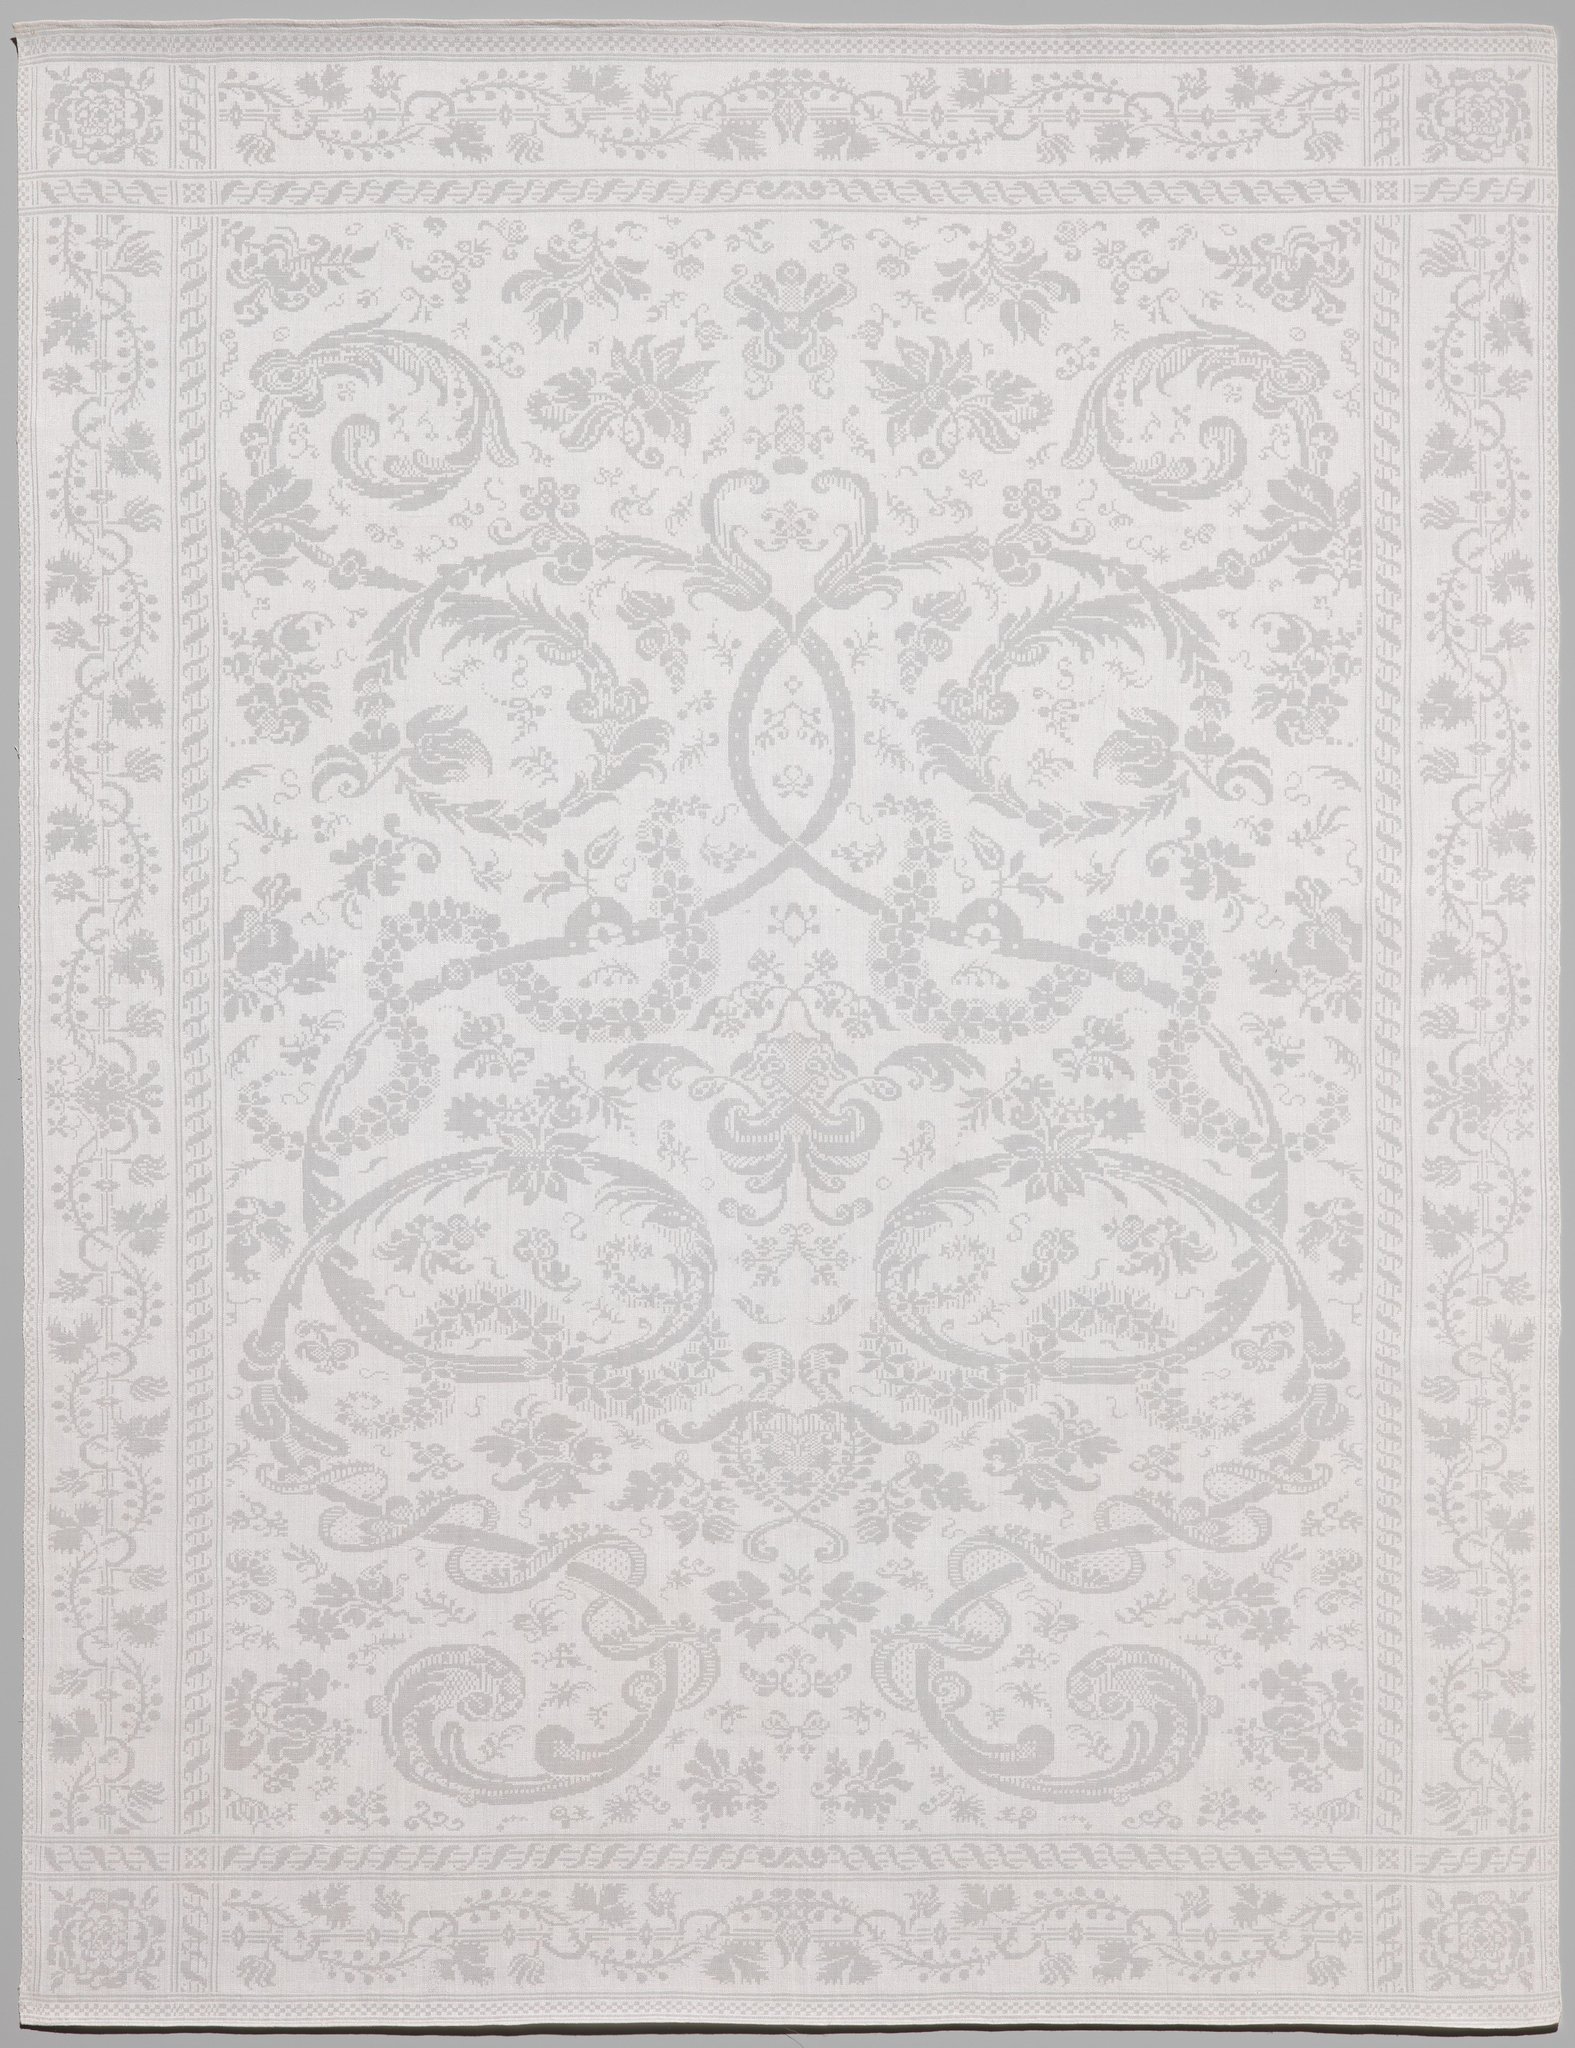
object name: napkin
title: Servet van linnendamast met een bloempatroon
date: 1692-1700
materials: linen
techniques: damask, weave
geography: northern netherlands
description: Wit linnendamasten servet met patroon van voluten, merk IS 24.